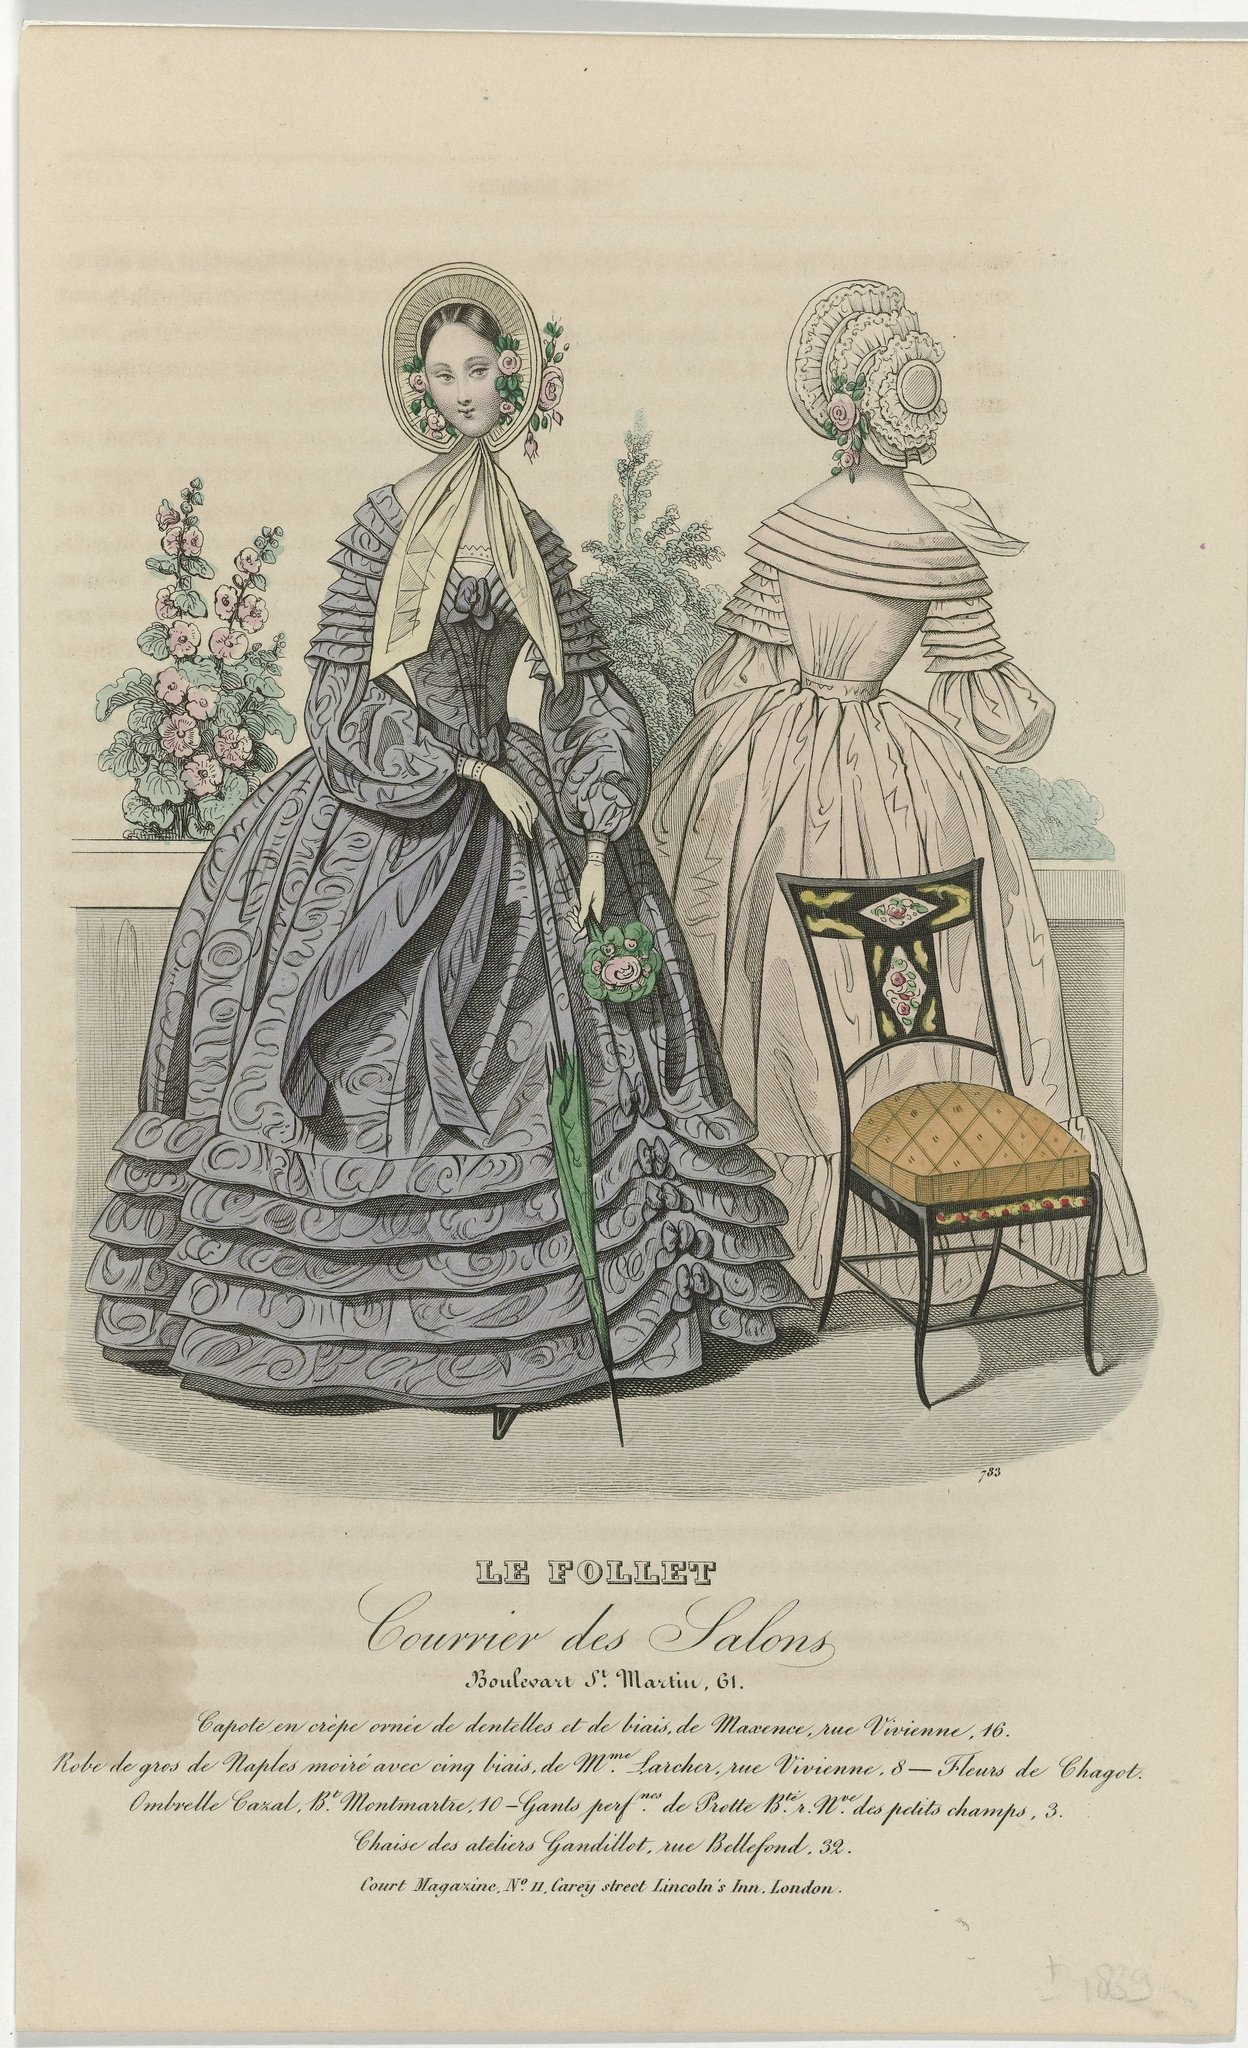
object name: fashion print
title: Le Follet Courrier des Salons, 1836, No. 783: Capote en crèp (...)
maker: Anonymous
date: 1836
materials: paper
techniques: engraving, hand coloring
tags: cut flowers; nosegay, bunch of flowers, head-gear (capote) (+ women's clothes), lace (+ women's clothes), fashion plates, gloves, mittens, etc. (+ women's clothes), dress, gown (+ women's clothes), chair, parasol, sunshade (+ women's clothes)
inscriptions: caption: ‘Capote en crêpe ornée de dentelles et de biais, de Maxence, rue Vivienne, 16. Robe de gros de Naples moiré avec cinq biais, de M.me Larcher, rue Vivienne, 8 - Fleurs de Chagot. Ombrelle Cazal, B.t Montmartre, 10 - Gants perf.nes de protte N.té r. N.ve des petits champs, 3. Chaise des ateliers Gandillot, rue Bellefond, 32.’, title: ‘Le Follet Courrier des Salons’, address: ‘Boulevart S.t Martin, 61. / Court Magazine, No.11, carey street Lincoln's Inn, London.’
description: Twee vrouwen, van wie één op de rug gezien, bij een balustrade. Volgens het onderschrift: 'capote' van crêpe versierd met kant en biaisband, van Maxence. Japon van 'gros de Naples moiré' met vijf biaisbanden van Larcher. Bloemen van Chagot. Parasol van Cazal. Handschoenen van Protte, gepatenteerd. Stoel uit de ateliers van Gandillot. Prent uit het modetijdschrift Le Follet Courrier des Salons (novembre 1829- octobre 1882).